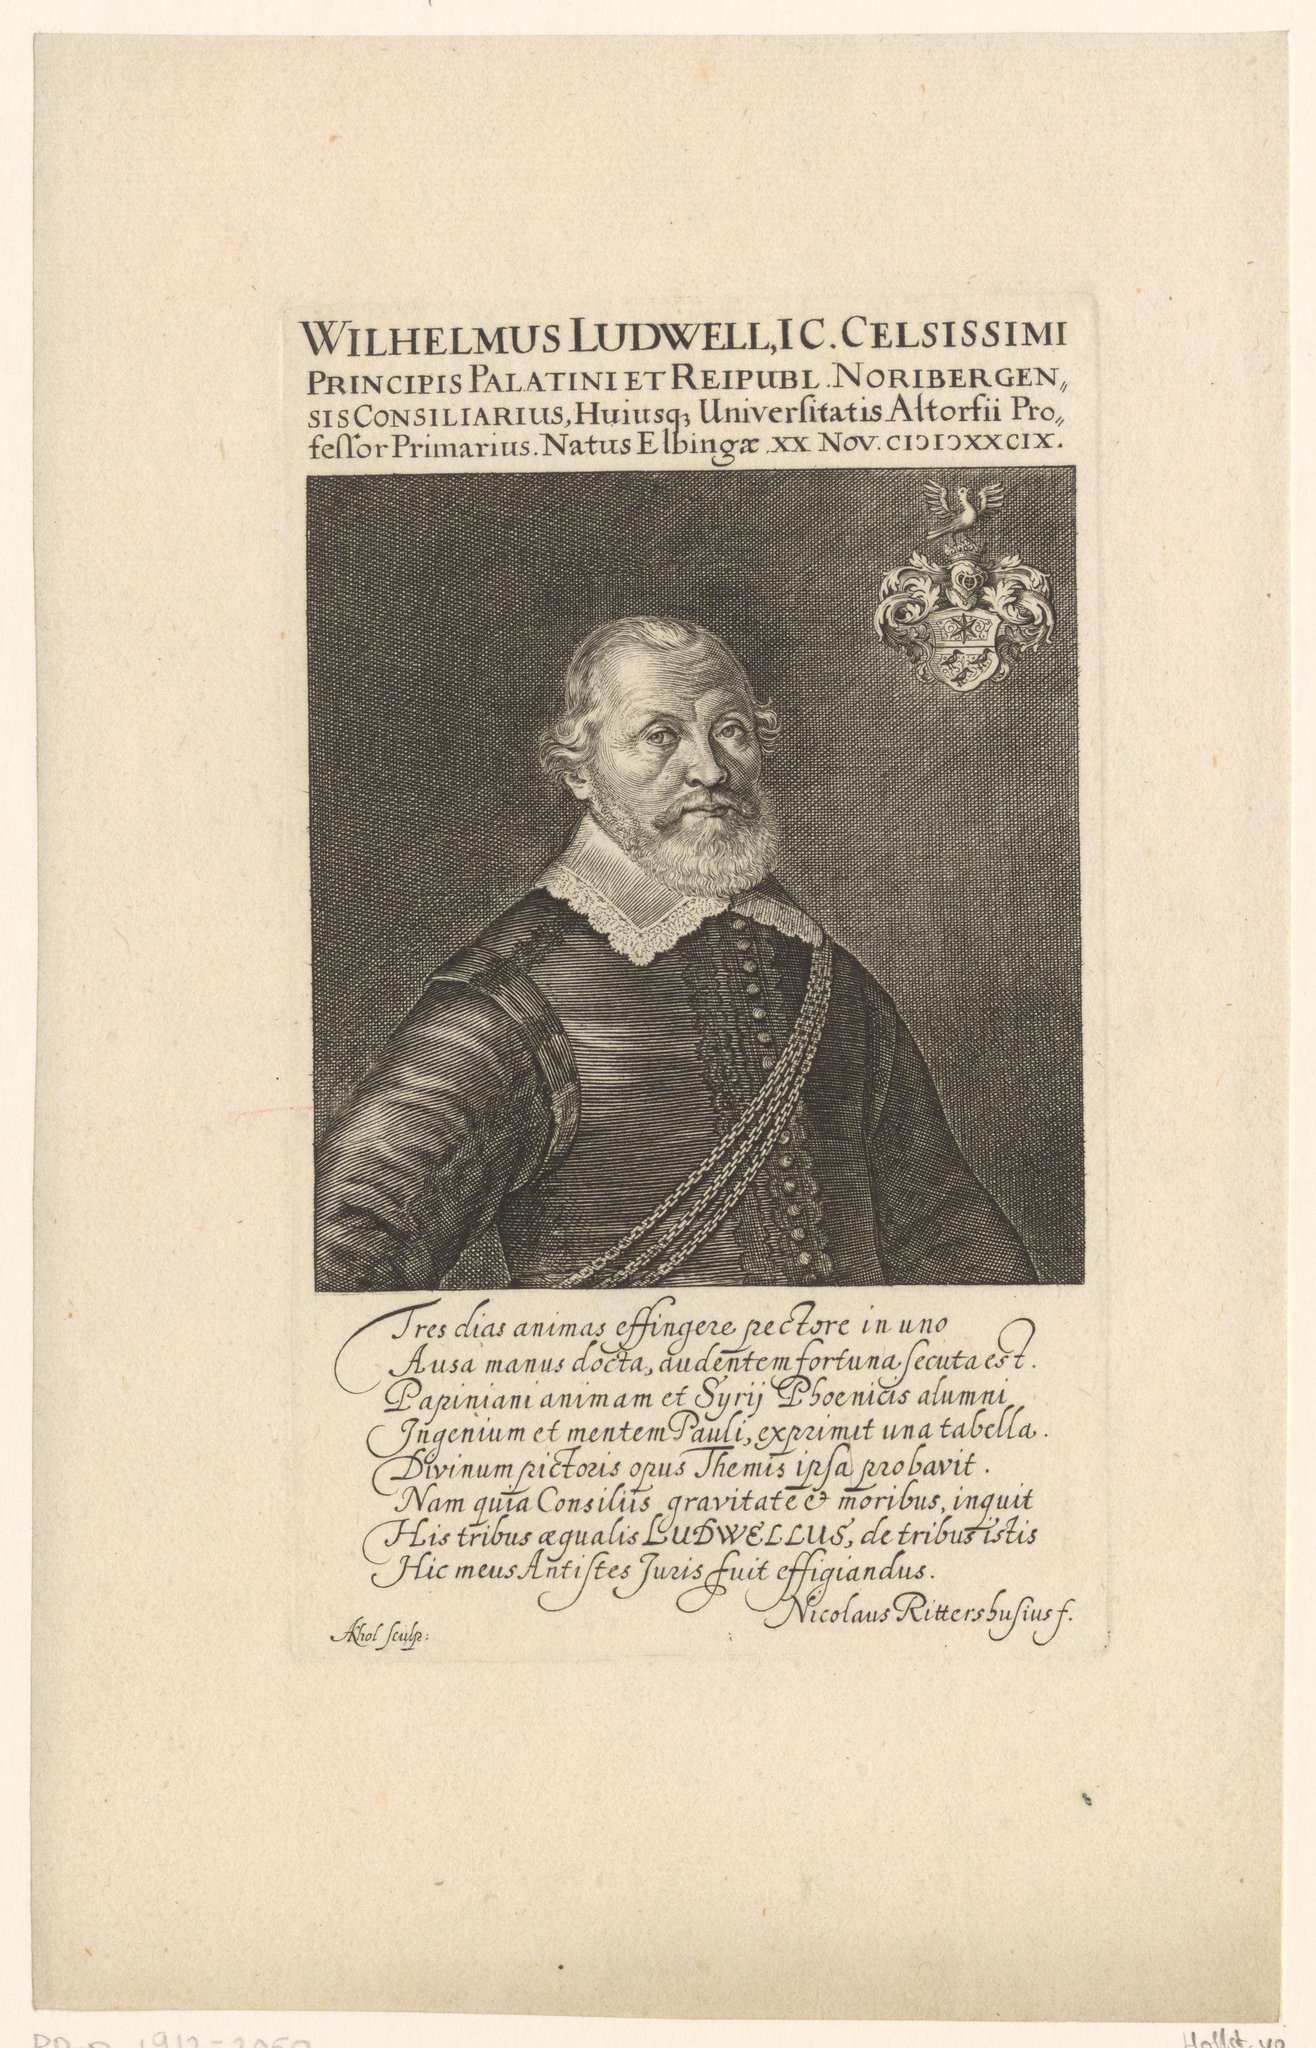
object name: print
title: Portret van Wilhelm Ludwell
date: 1634-1657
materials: paper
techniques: engraving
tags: further education (+ portrait of teacher, professor), historical persons, lawyer, attorney at law, counsellor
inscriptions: collector's mark: Lugt 2228